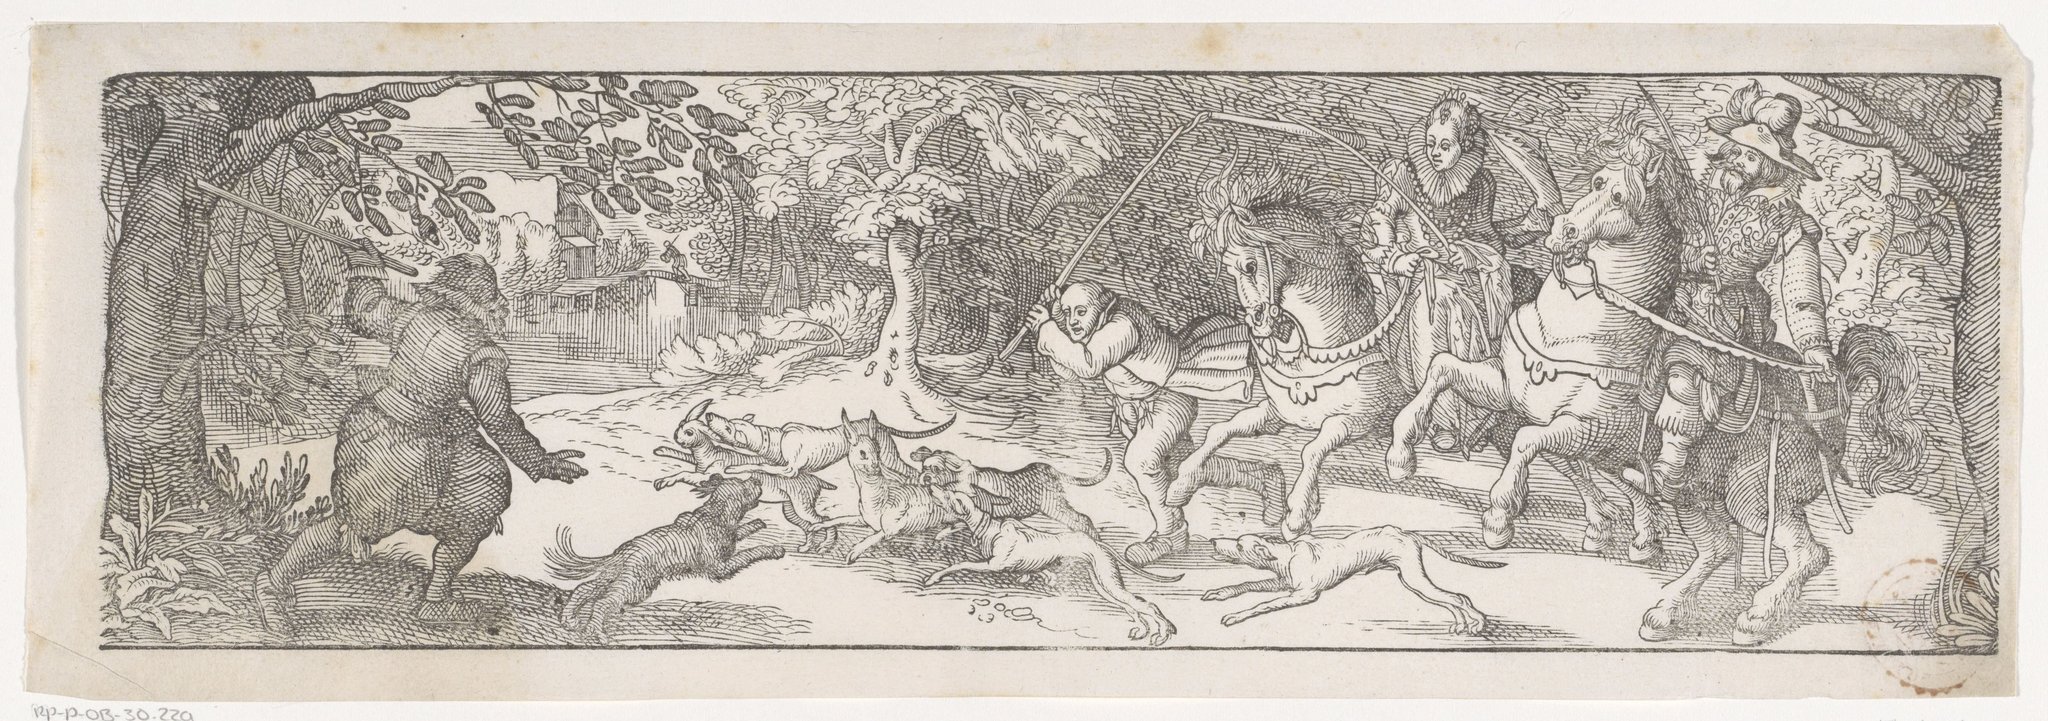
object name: print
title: Jachttaferelen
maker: philips serwouters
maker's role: print maker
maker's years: 1591-1650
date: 1601-1650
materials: paper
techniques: woodcut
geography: netherlands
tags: hunting dogs, rodents: hare, hunters hunting (n.b.: in 1988-1990 this notation denoted the concept of 43c11421 'hunters resting during the hunt'), hare-hunting, rabbit-hunting, horse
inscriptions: collector's mark: Lugt 240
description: Vier jagers met paarden en jachthonden hebben een aantal hazen ingesloten en zullen deze met hun stokken doden.